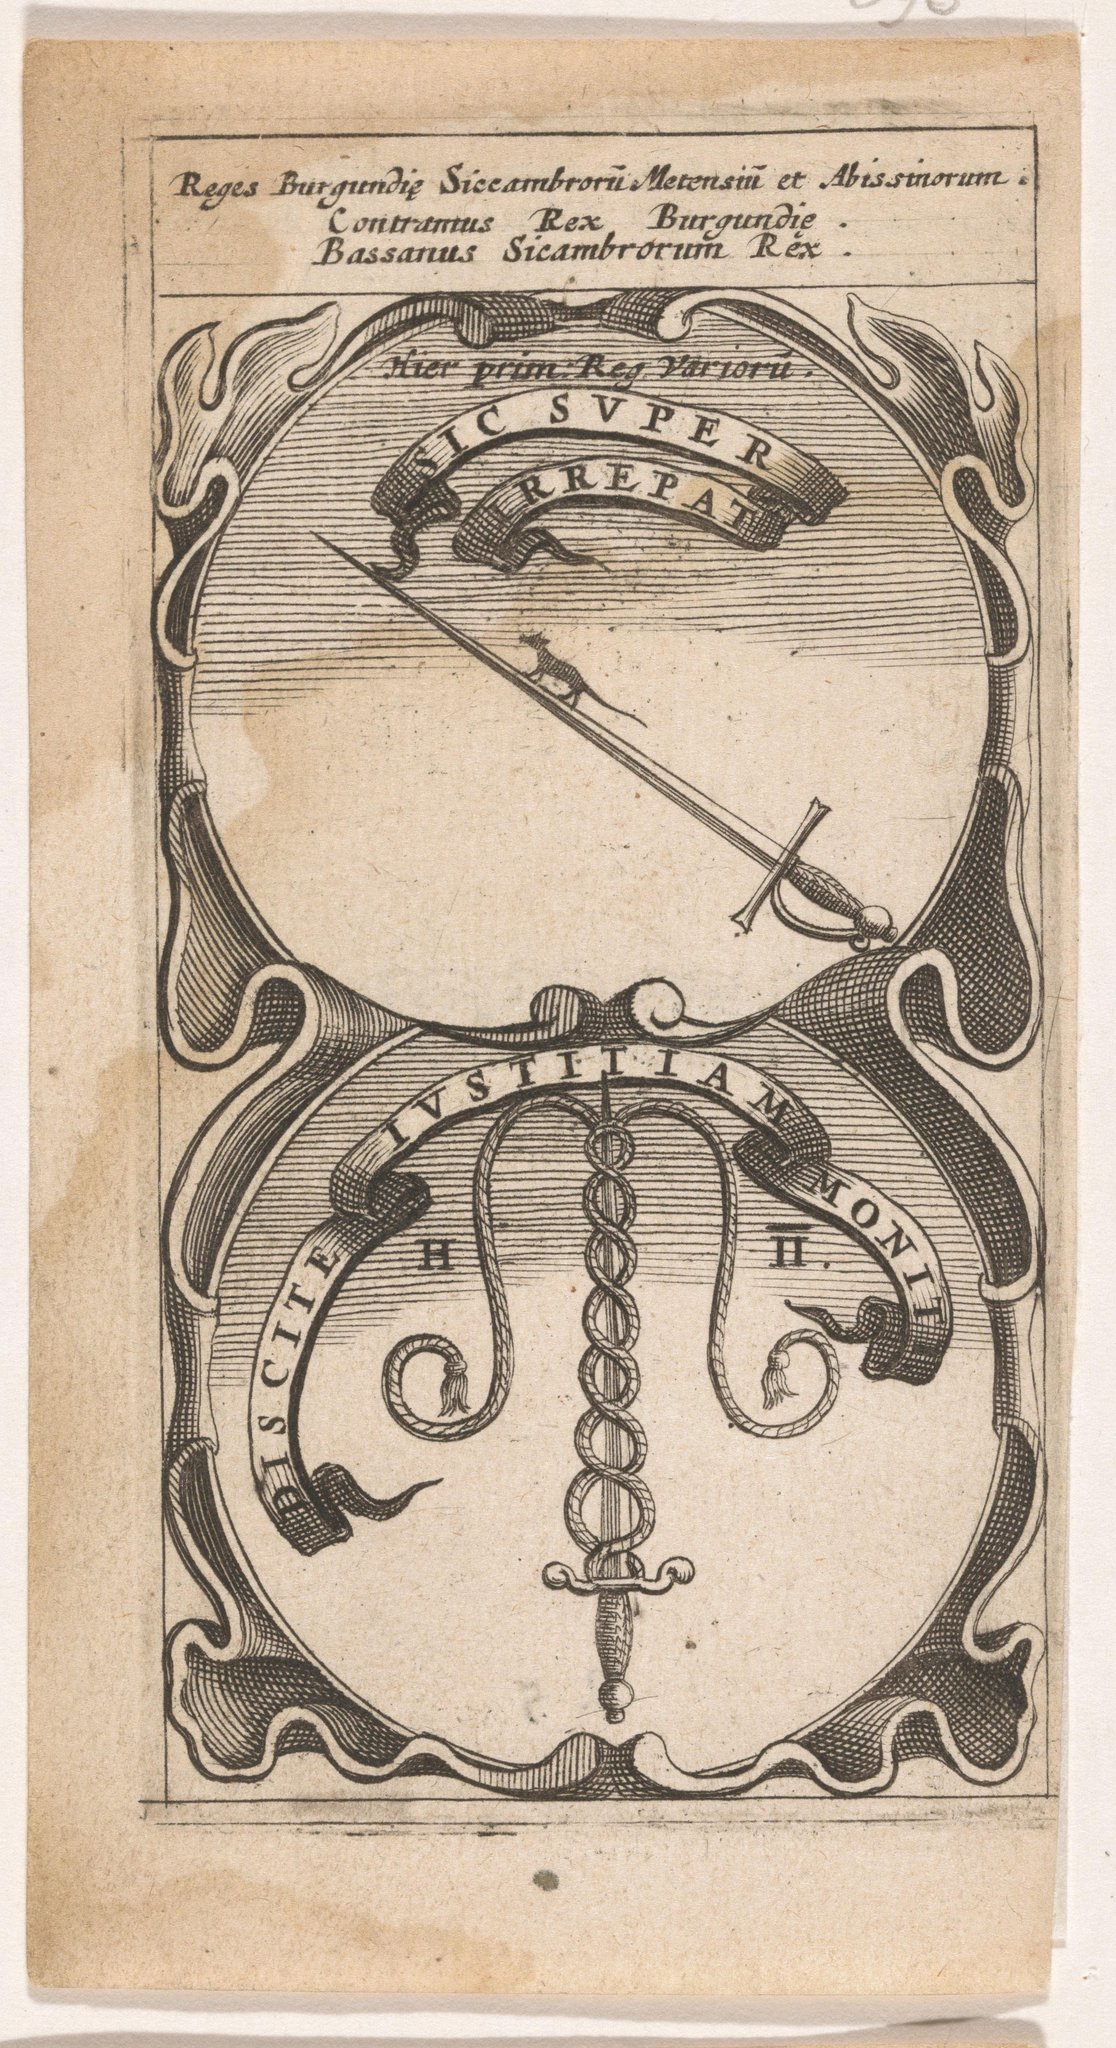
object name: print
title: Sic Super Irrepat / Discite Justitiam Moniti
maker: Anonymous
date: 1666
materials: paper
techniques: engraving, letterpress printing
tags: animals, hacking and thrusting weapons: sword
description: Een embleem met twee voorstellingen. Boven een schuin zwaard met op het lemmet een vierpotig niet identificeerbaar dier. Onder is om het lemmet een touw gewikkeld. Het betreffen mogelijk deviezen van Contranus, een koning van Bourgondië, en koning Bassanus van Sicambria.